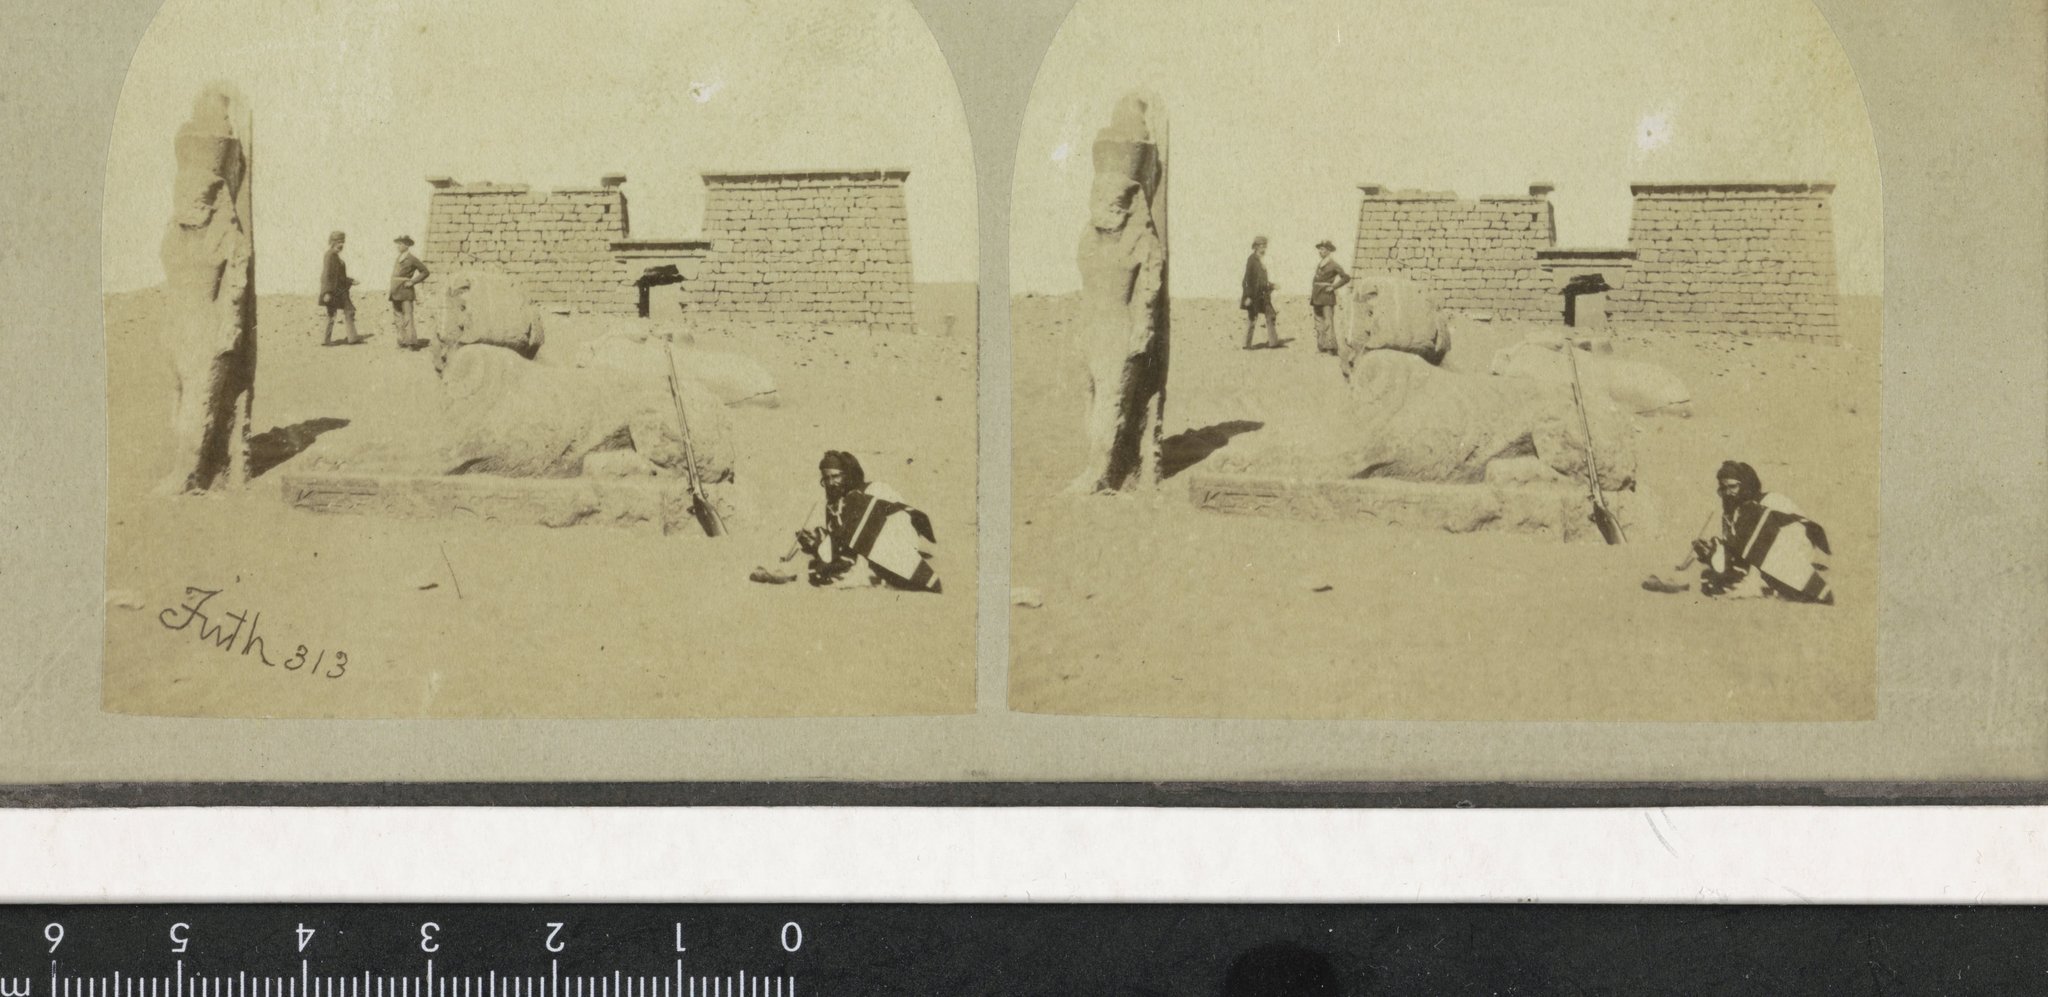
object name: photograph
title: Kolossen en sfinxen bij de toegangsweg tot de tempel van Wadi es-Saboea, Egypte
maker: francis frith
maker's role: publisher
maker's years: 1822-1898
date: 1856-1860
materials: cardboard, glass, paper, photographic support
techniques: albumen print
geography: great britain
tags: egypte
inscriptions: inscription: ‘Frith 313’, label: ‘No. 13 / Nubie. / Les colosses de la plaine, les célèbres / Statues de Memnon, a Thèbes.’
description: Op de voorgrond een kolos en twee sfinxen, op de achtergrond de tempel.